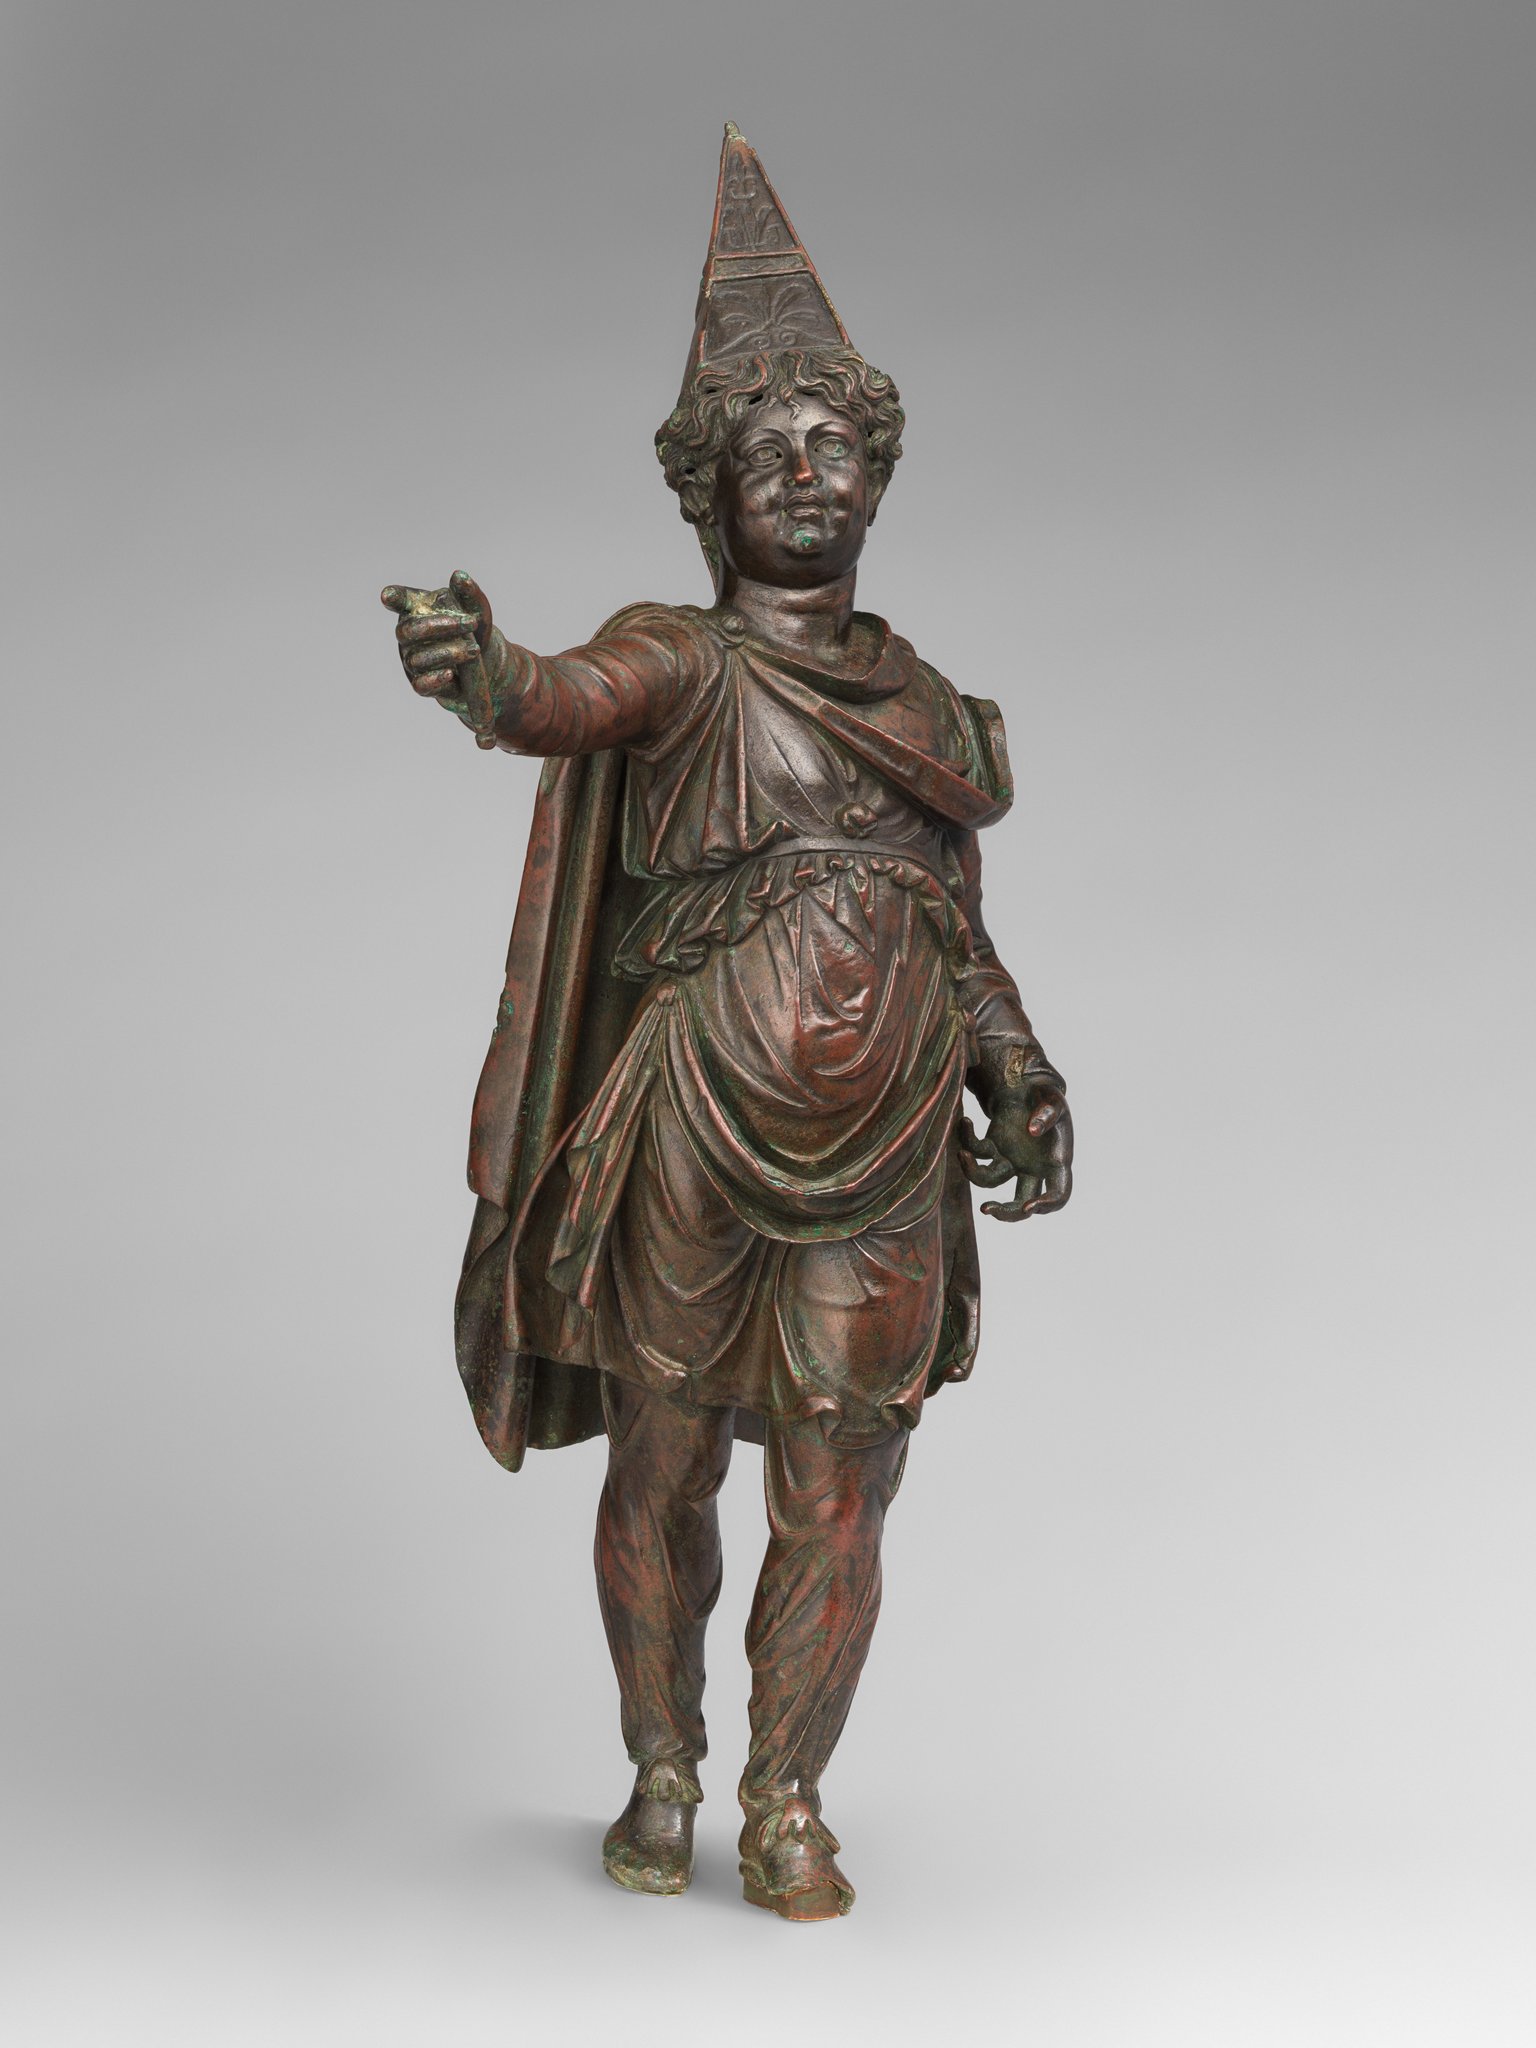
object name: statue of a boy in tiara and oriental dress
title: Bronze figure of a boy in Eastern dress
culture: greek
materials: bronze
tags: boys